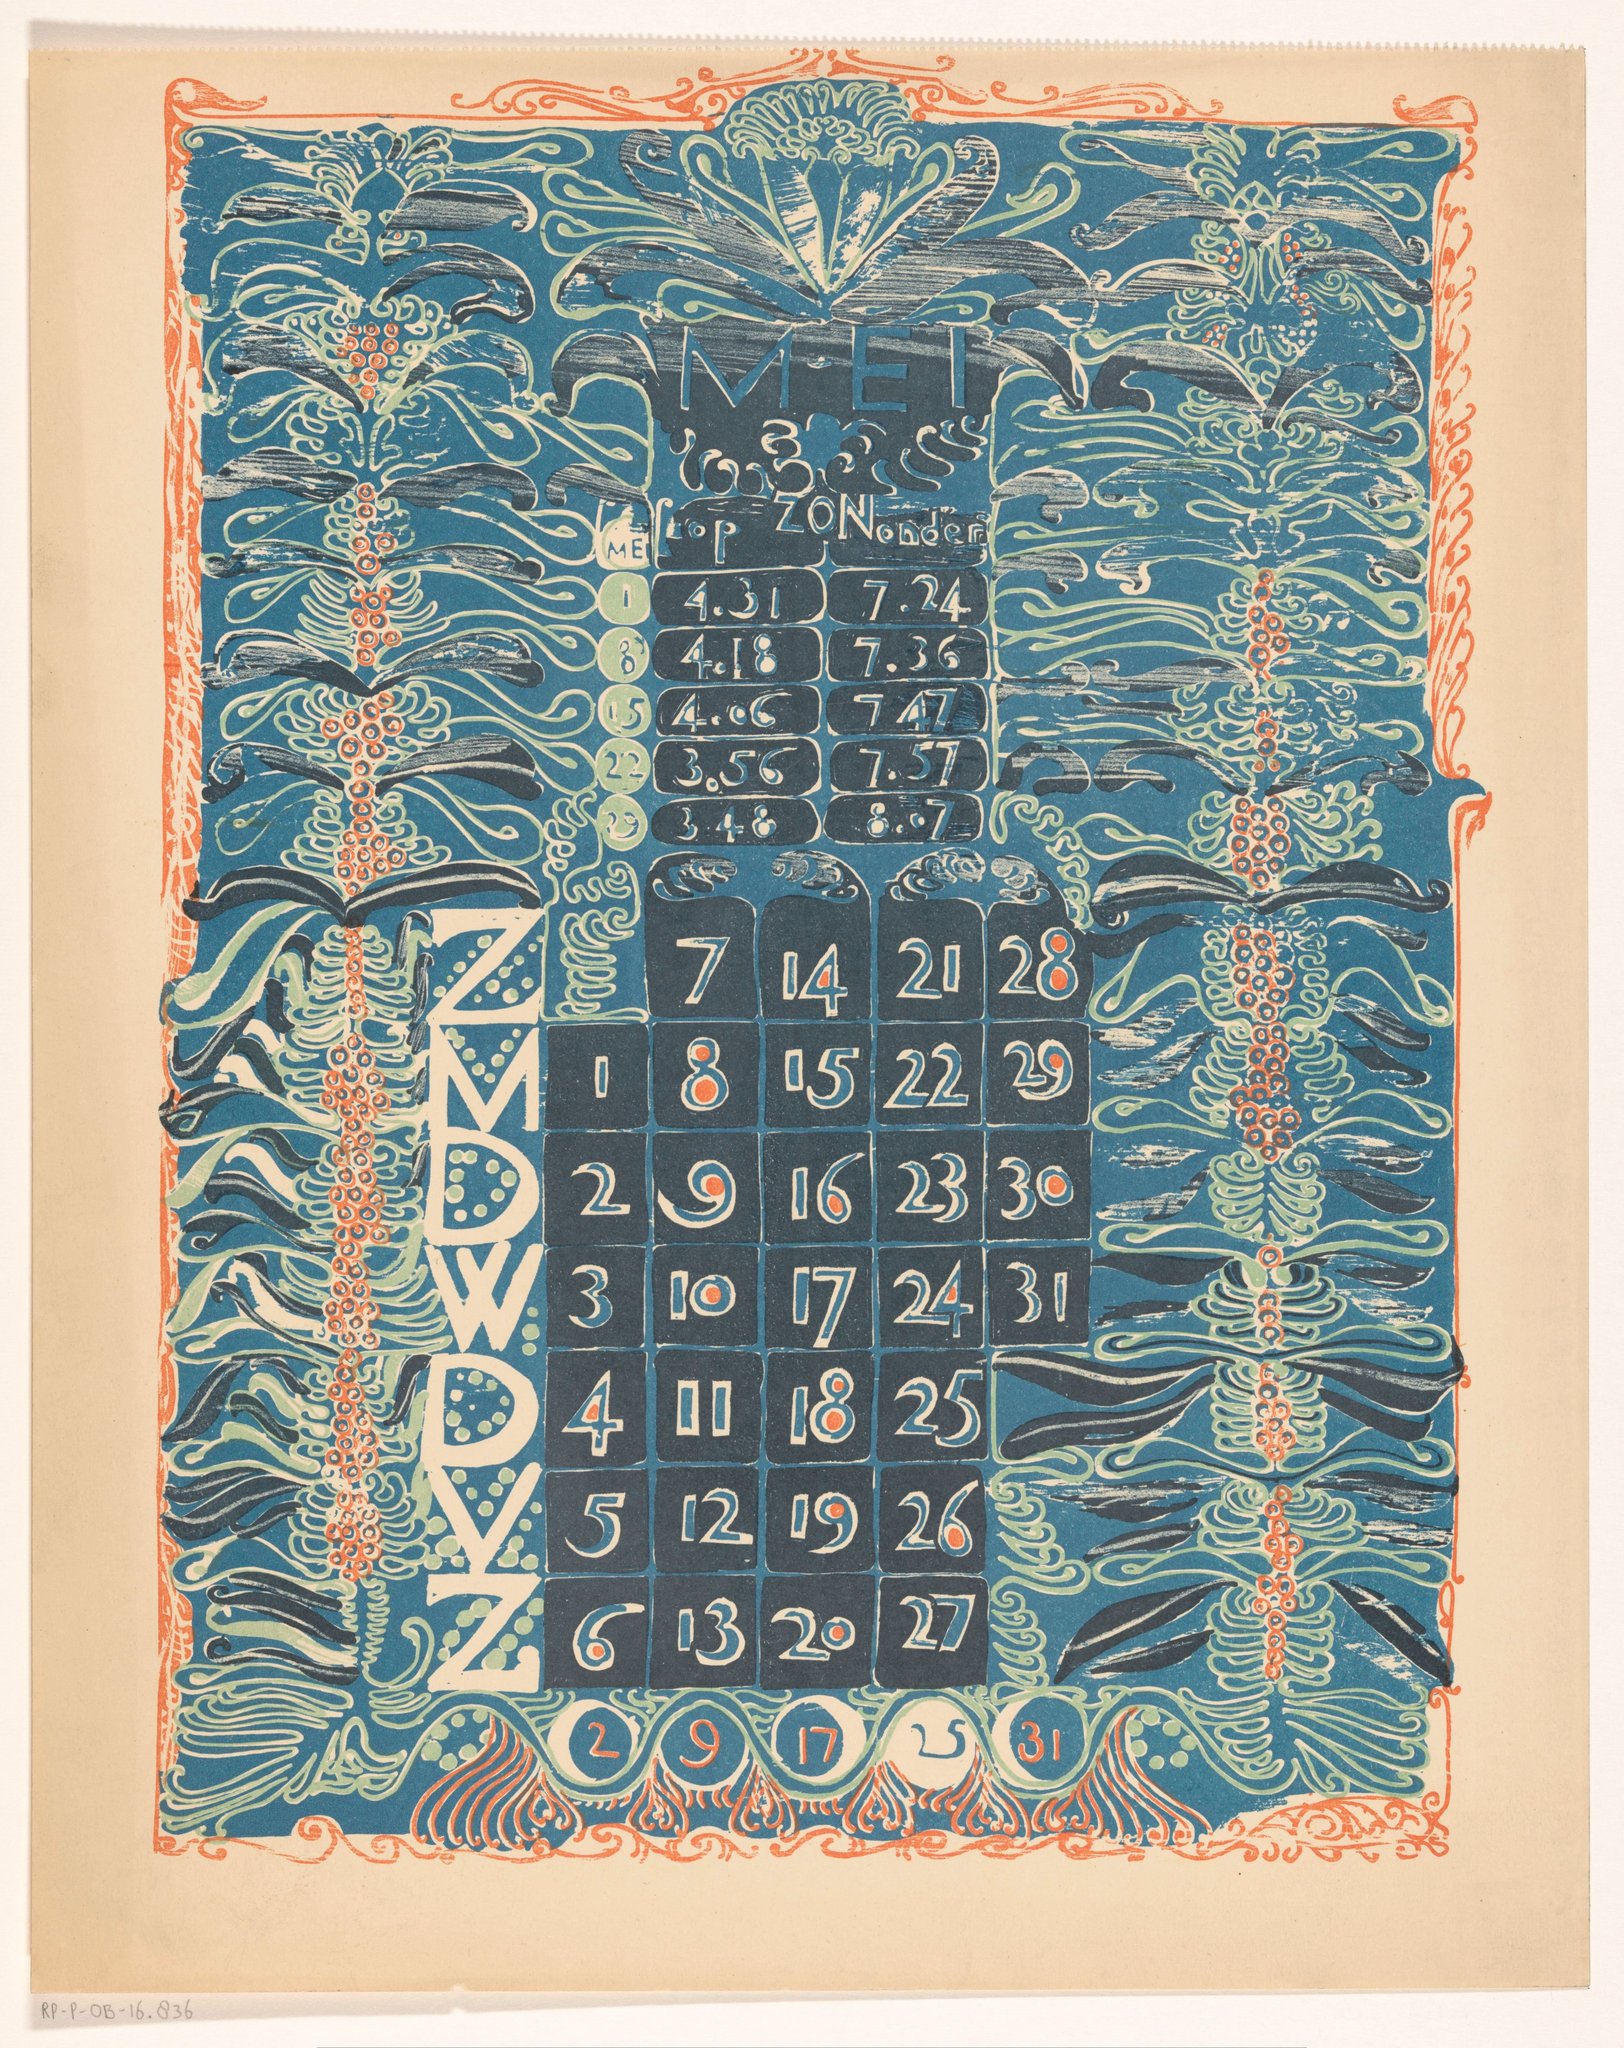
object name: print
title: Kalenderblad mei 1899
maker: carel adolph lion cachet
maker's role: draughtsman, print maker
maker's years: 1864-1945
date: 1899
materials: paper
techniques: lithograph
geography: amsterdam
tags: may ~ other concepts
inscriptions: collector's mark: Lugt 2228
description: In 1898 vervaardigden Gerrit Willem Dijsselhof, Carel Adolph Lion Cachet en Theo Nieuwenhuis samen een kalender voor het jaar 1899. Lion Cachet nam het ontwerp van de maanden februari, mei, augustus en november op zich.